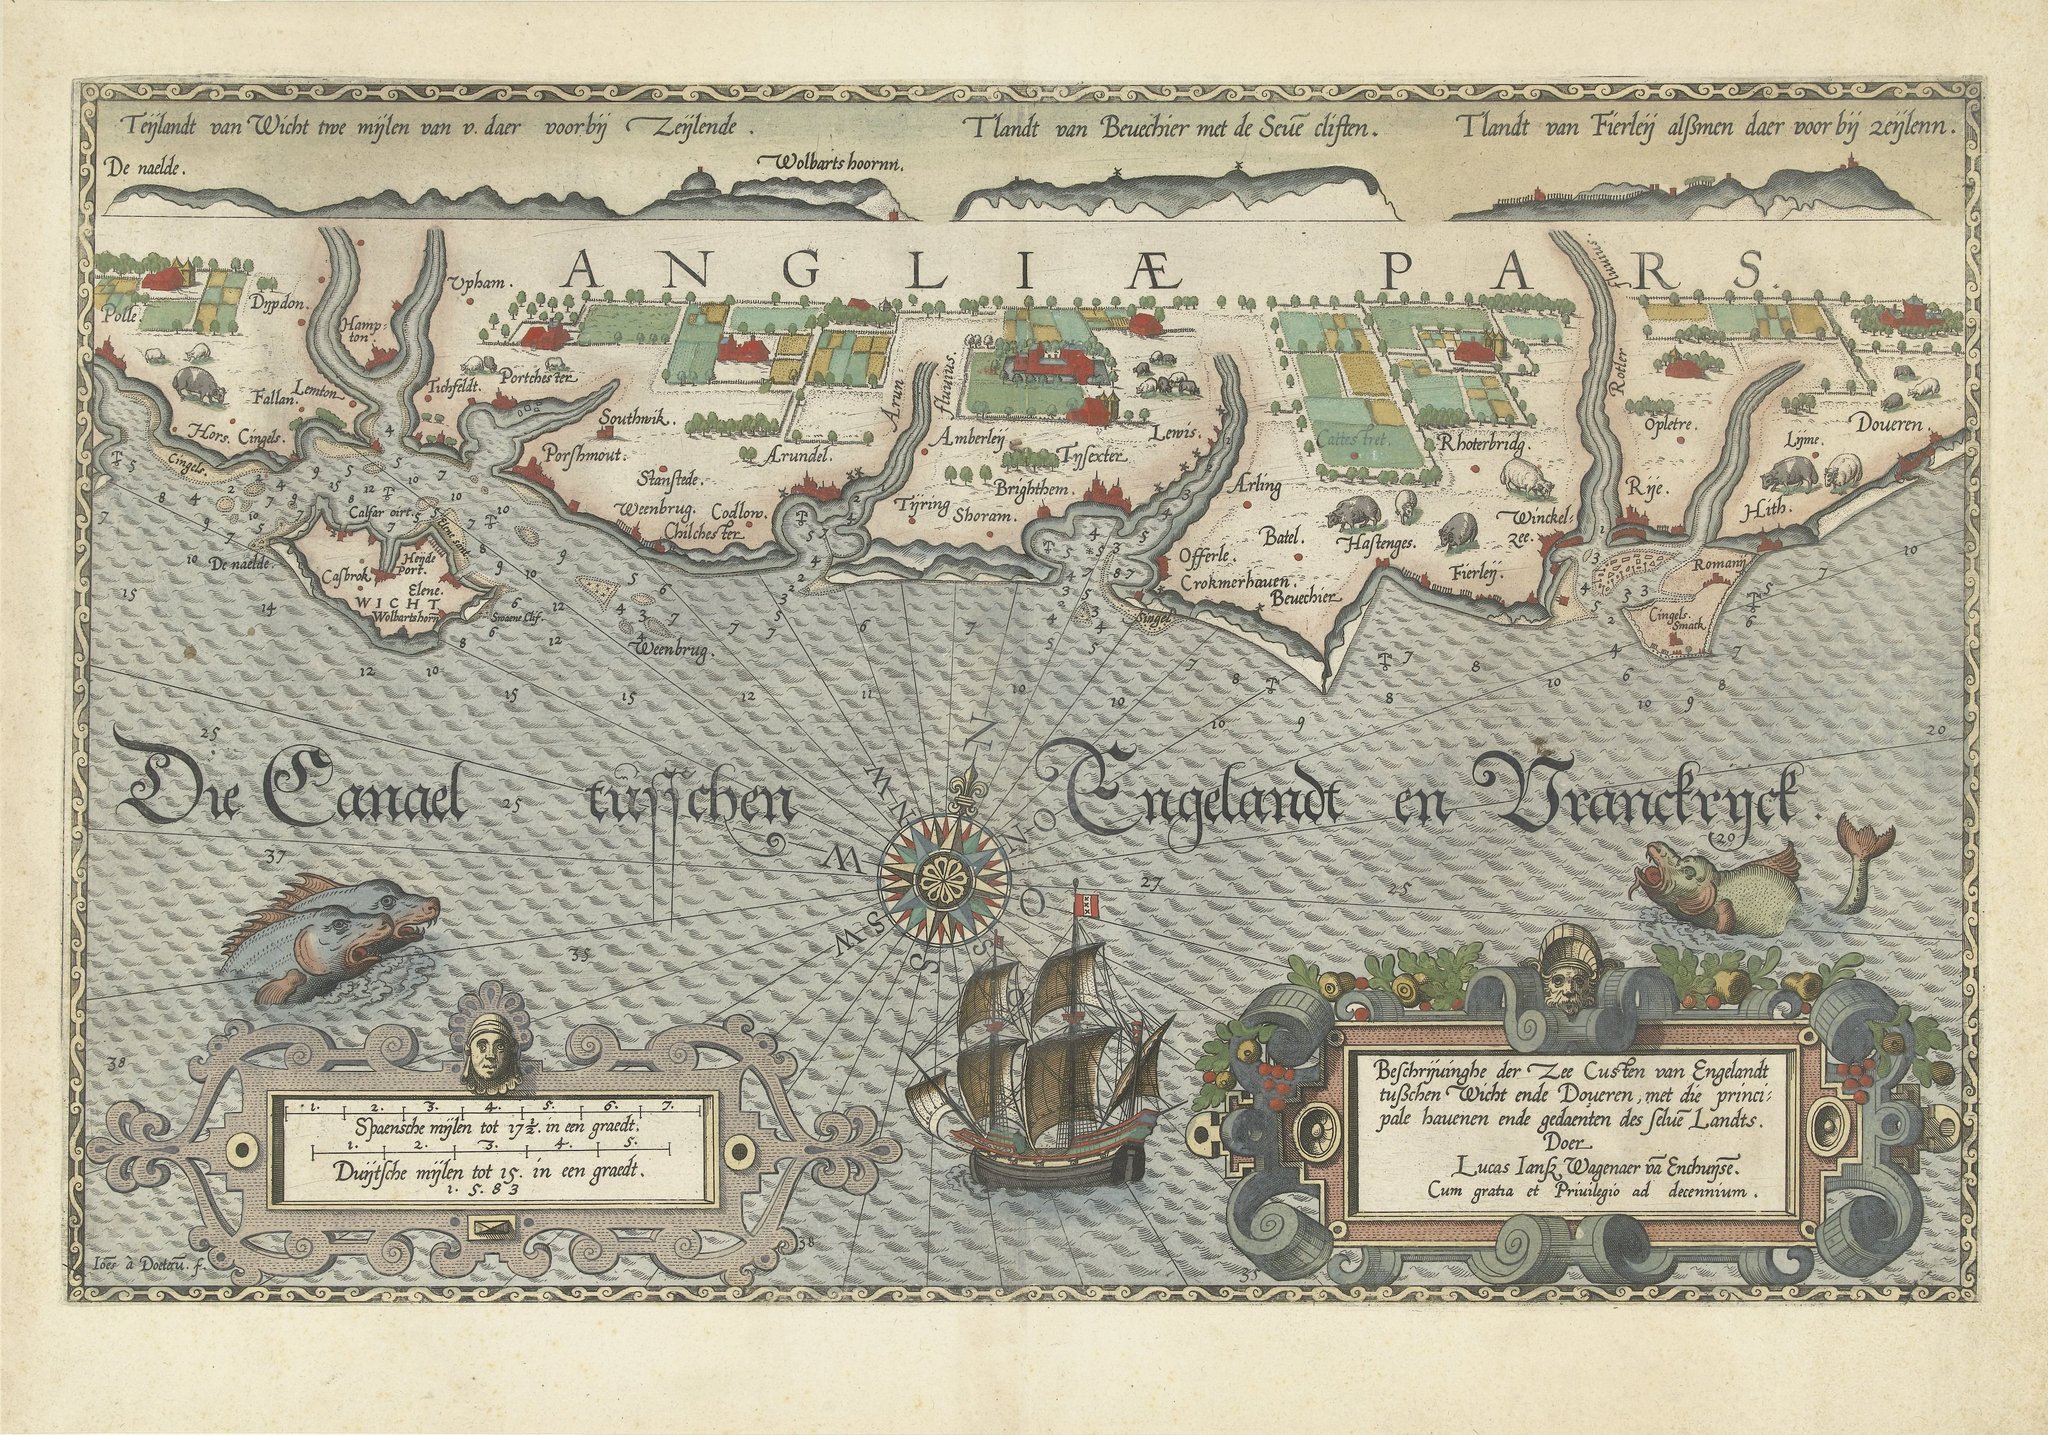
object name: print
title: Beschrijvinghe der Zee Custen van Engelandt tuschen Wicht ende Doueren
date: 1580-1583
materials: paper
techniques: engraving, hand coloring, letterpress printing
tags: representation of last judgement, with the archangel michael weighing the souls (or dividing the blessed and the damned), england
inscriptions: collector's mark: Lugt 2760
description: Kaart voor: L.J. Waghenaer. Spieghel der Zeevaerdt. Leiden: C. Plantijn, 1584-1605. Verschillende uitgaven.